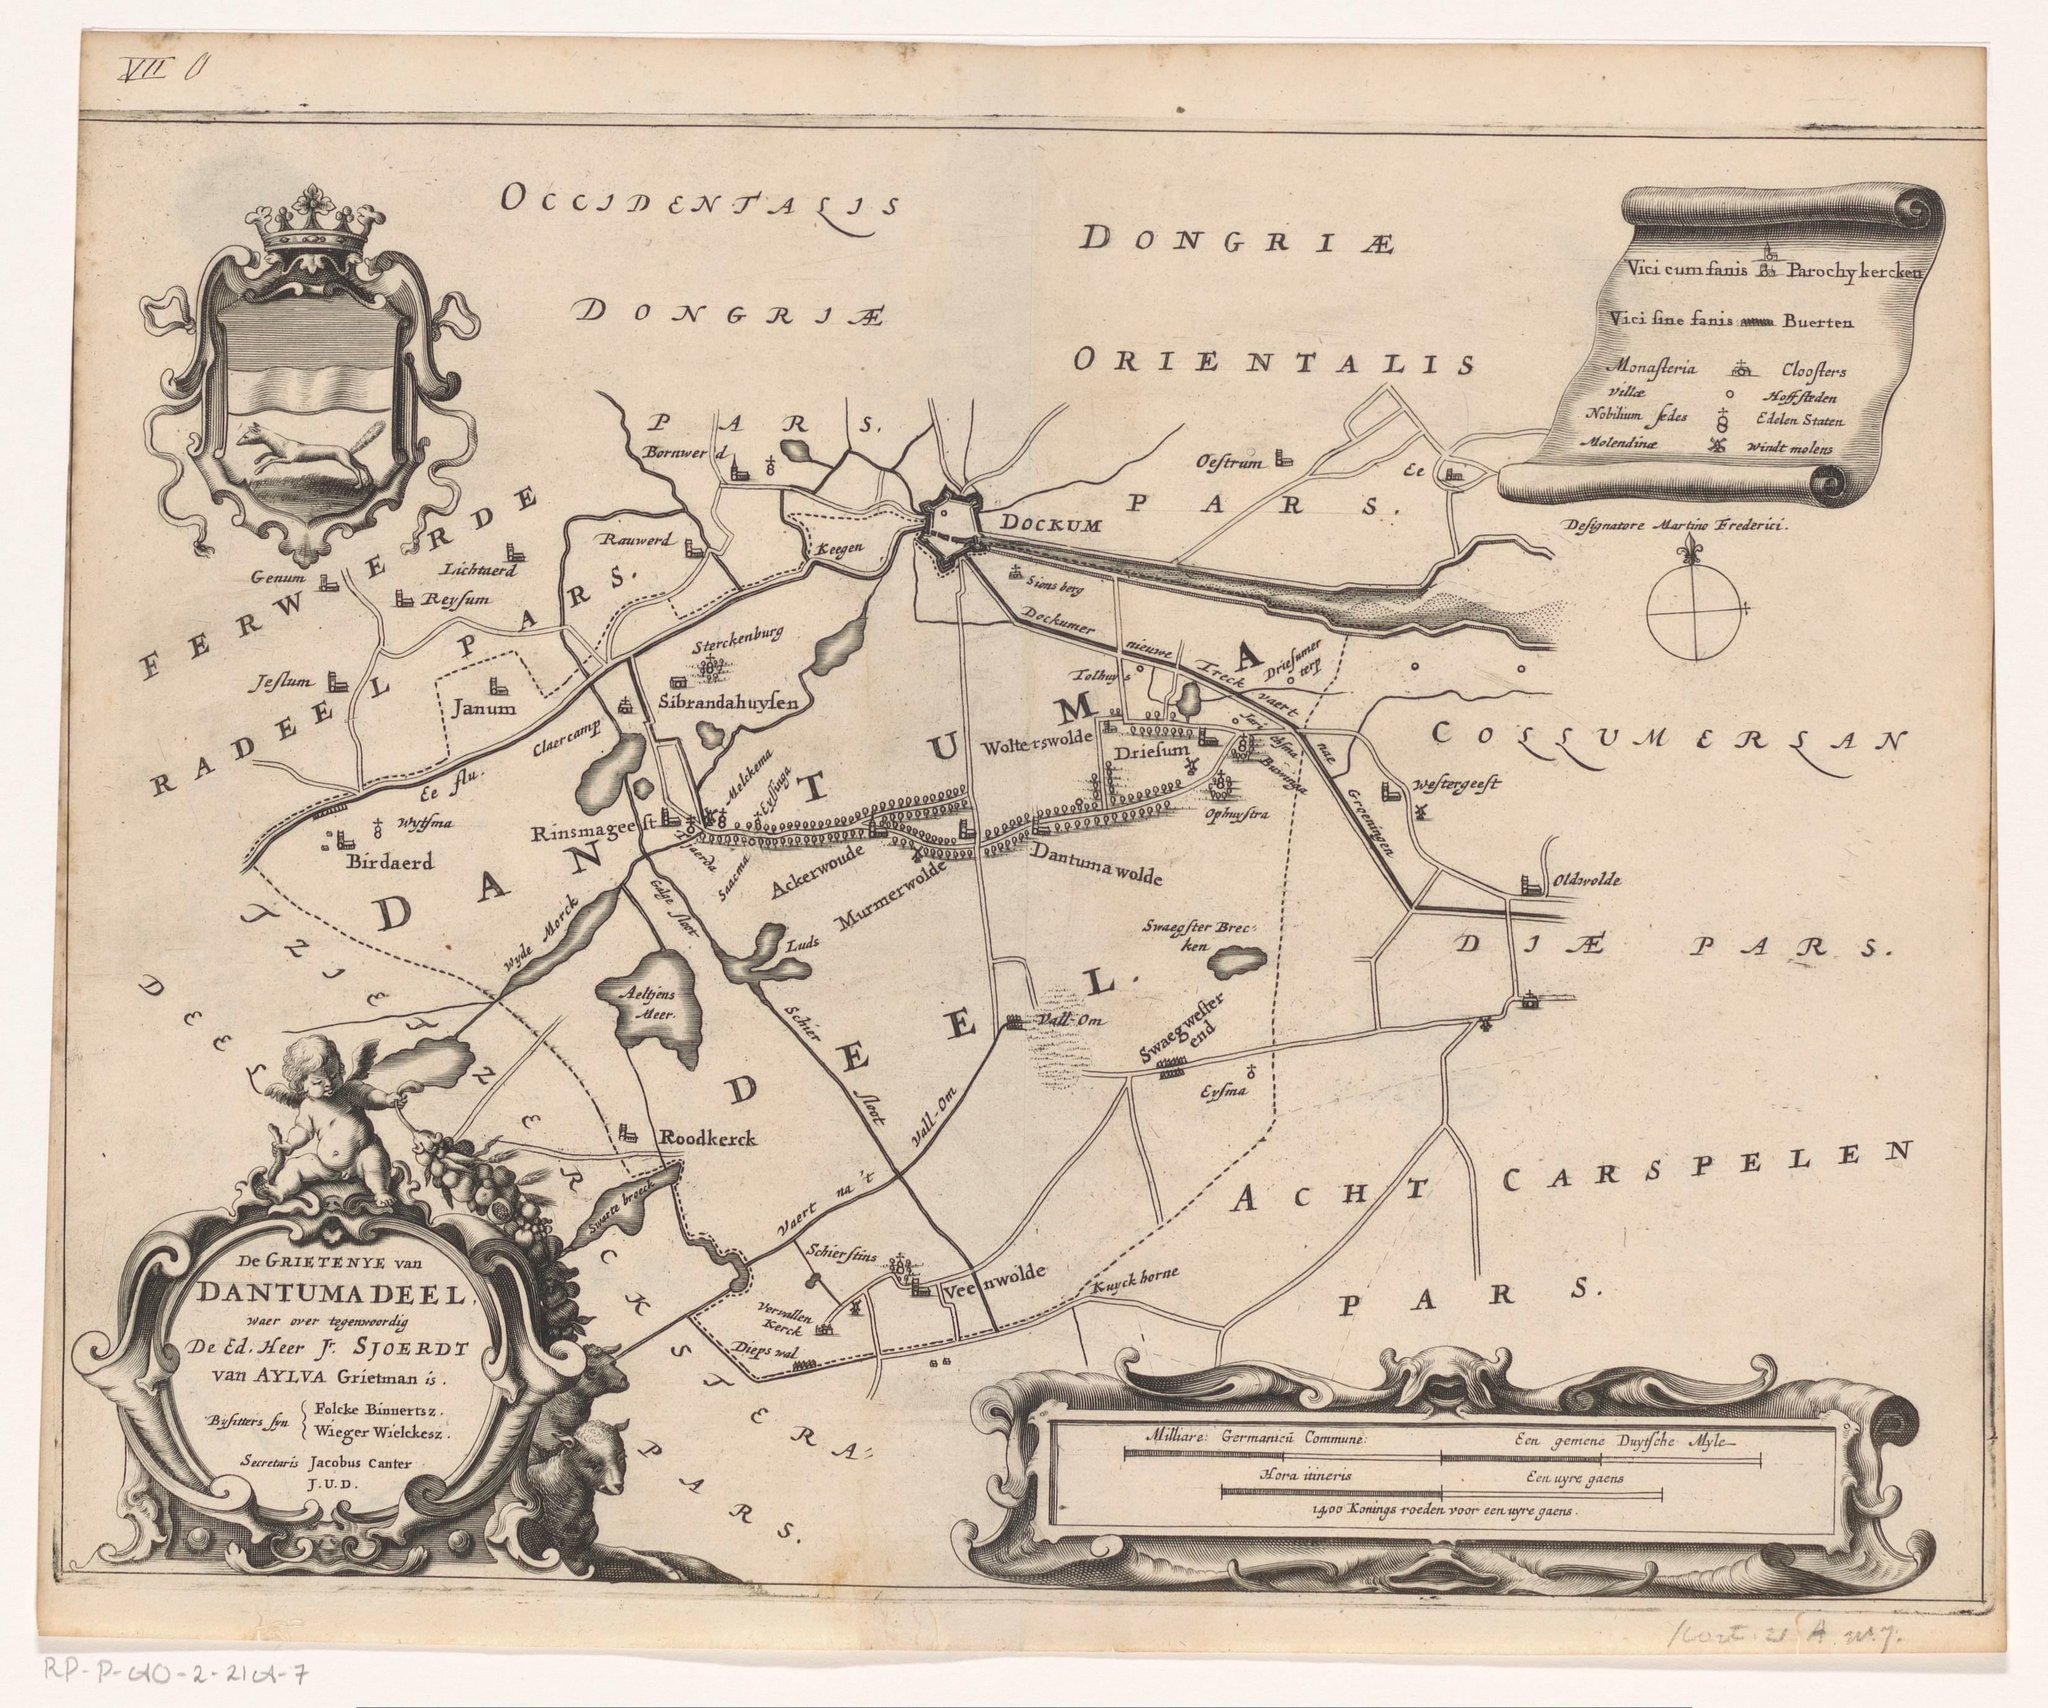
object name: print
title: Kaart van de grietenij Dantumadeel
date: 1664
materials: paper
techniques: engraving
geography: amsterdam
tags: coat of arms (as symbol of the state, etc.), maps of separate countries or regions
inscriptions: collector's mark: Lugt 2228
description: Linksboven het wapen van Dantumadeel, linksonder cartouche met titel en bestuurlijke informatie over de grietenij. Rechtsboven legenda, rechtsonder twee schaalstokken: Milliare: Germanicu commune / Een gemene Duytsche myle, Hora itineris / Een uyre gaens - 1400 konings roeden voor een uyre gaens.